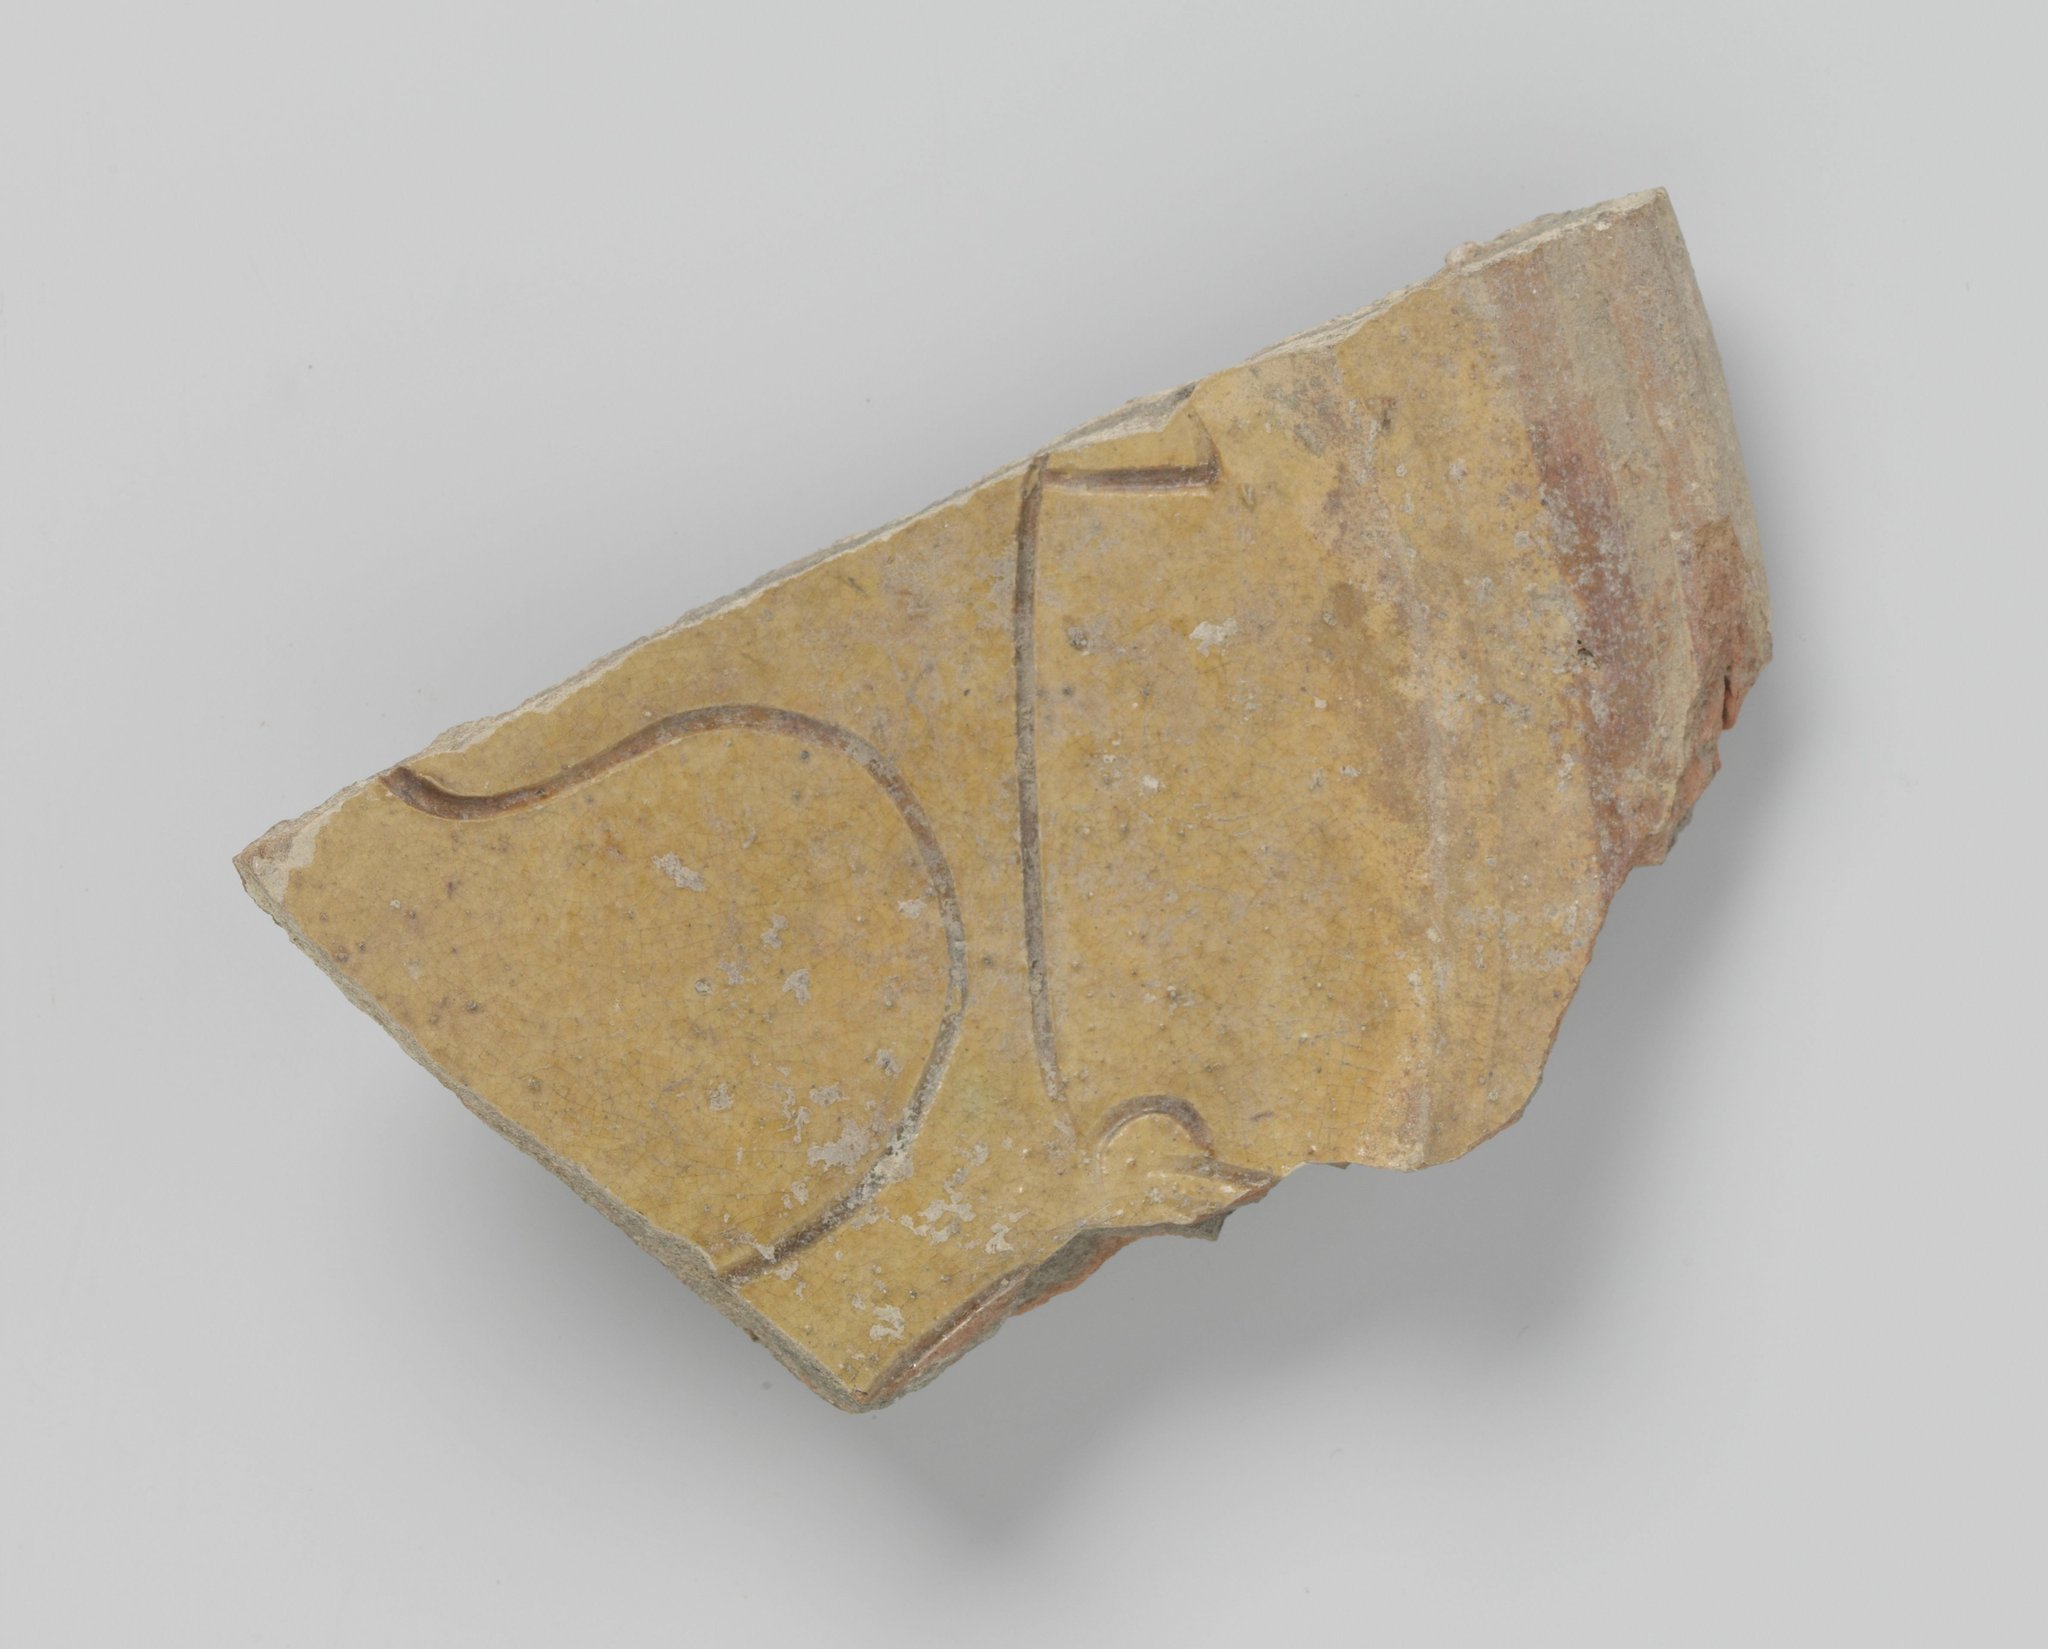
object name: fragment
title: Scherf van rode klei met witte sliblaag in loodglazuur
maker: Anonymous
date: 1625-1725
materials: earthenware, glaze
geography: england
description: Scherf van rode klei met witte sliblaag in loodglazuur, waarin een ornament gekrast. Gevonden in Londen, Middlesex Street dichtbij Liverpool Street Station.